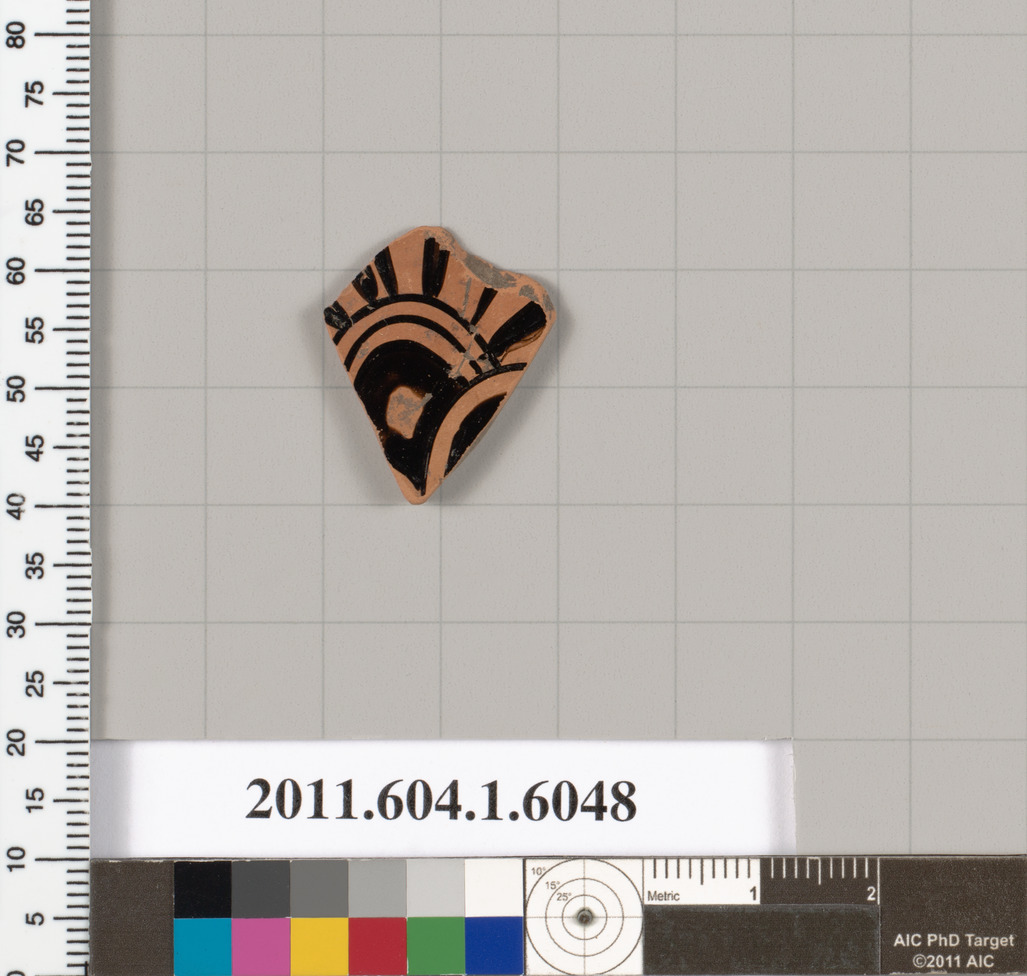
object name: kylix fragment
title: Terracotta fragment of a kylix (drinking cup)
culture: greek, attic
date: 510-500 BCE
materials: terracotta